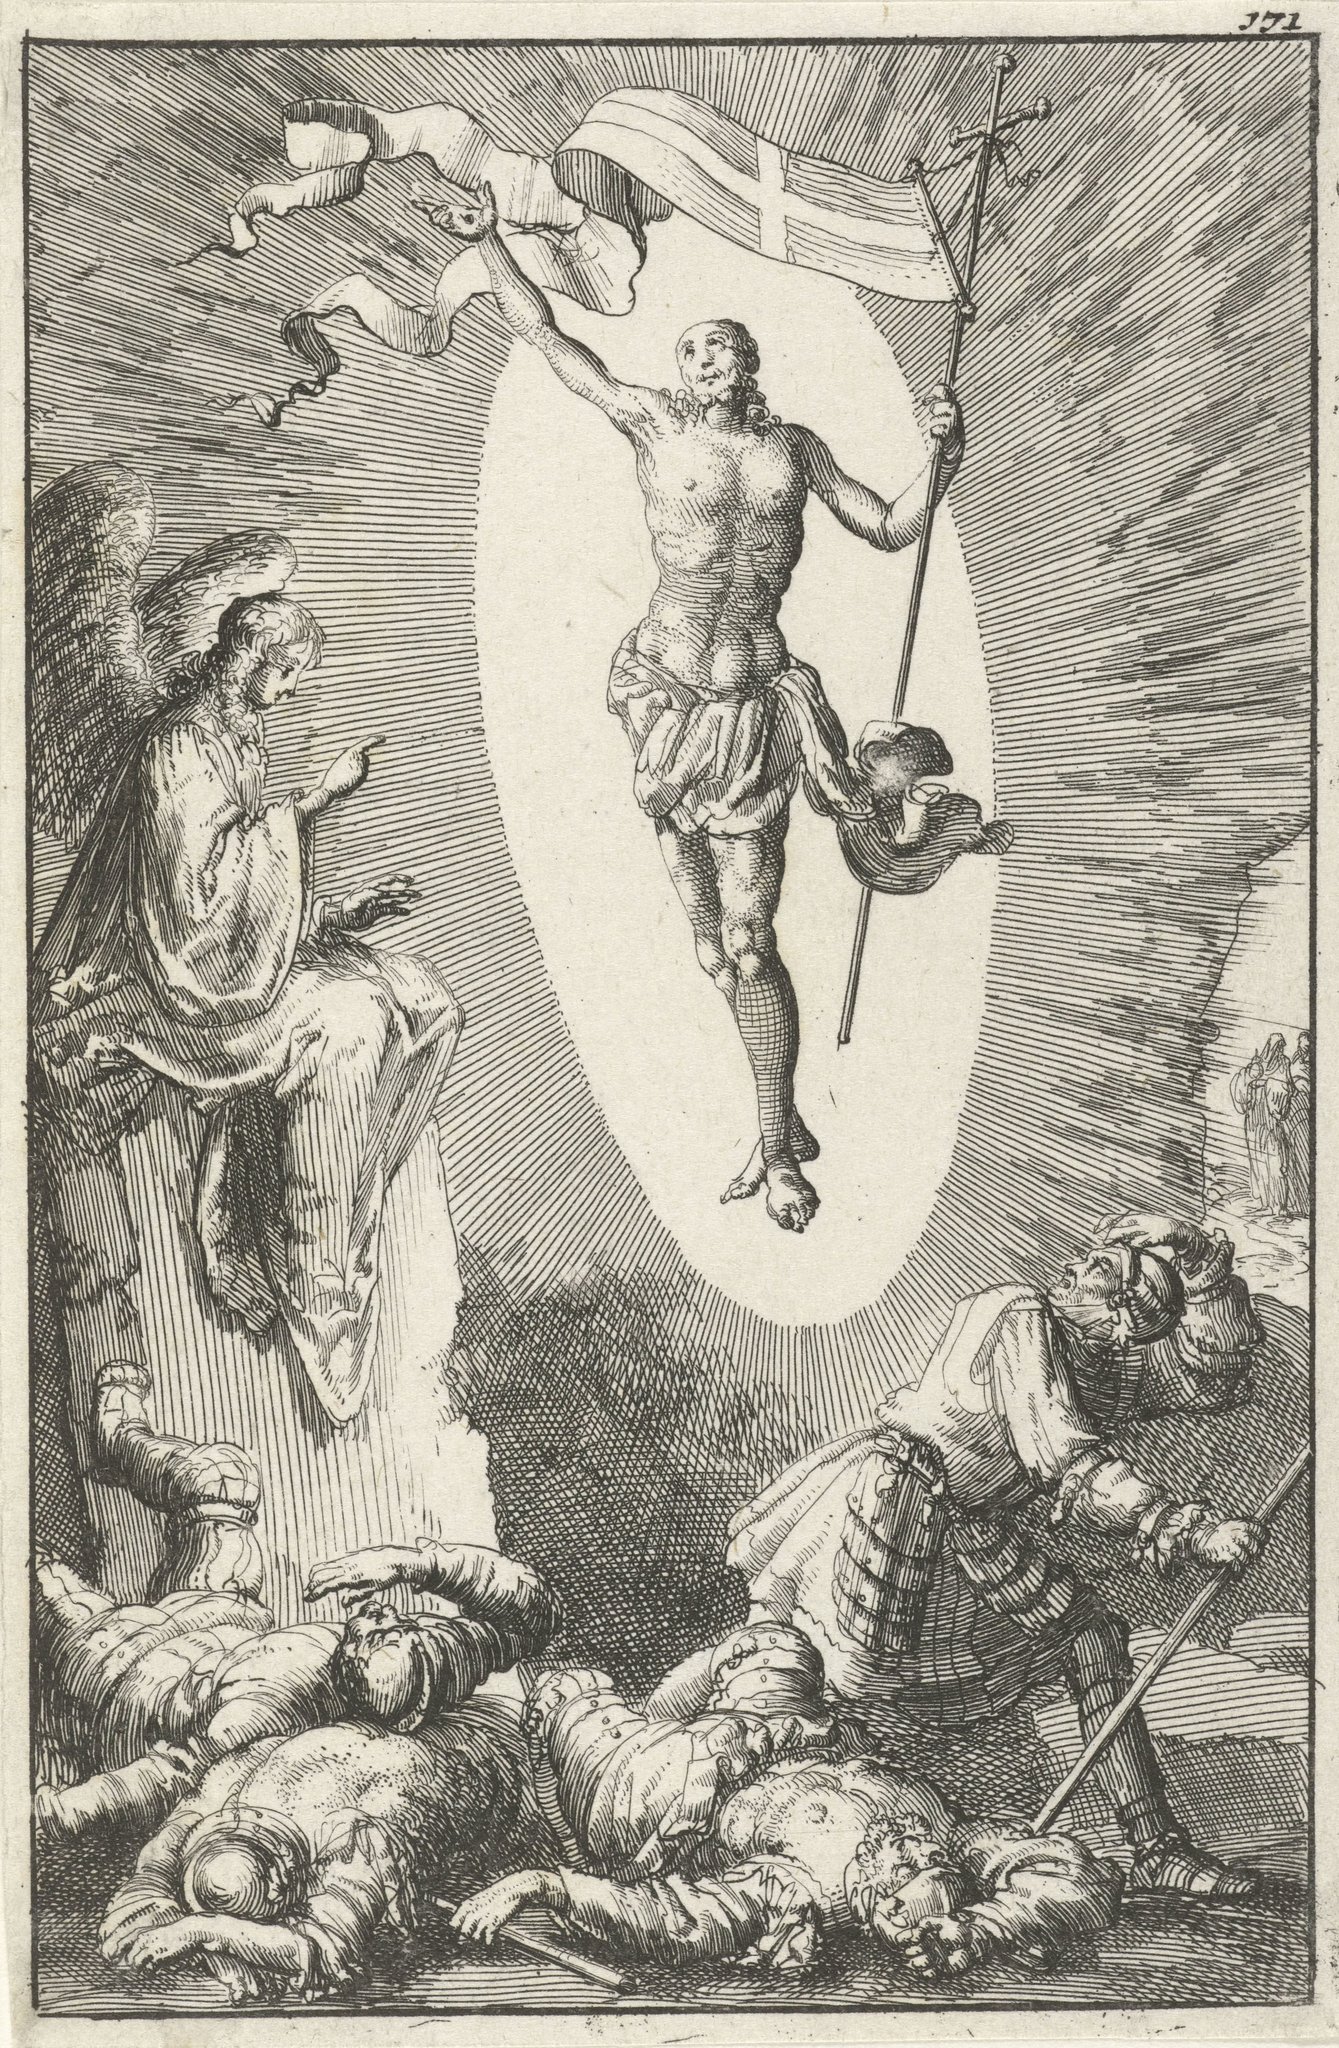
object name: print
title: Opstanding van Christus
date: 1684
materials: paper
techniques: etching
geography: amsterdam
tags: christ, usually holding a banner, arises from the grave; often combined with sleeping and/or frightened soldiers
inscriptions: collector's mark: Lugt 2228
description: Illustratie uit: Langedult, Petrus. Christus lydende, en verheerlykt. Het allerheylsaamste treur-spel. Amsterdam: Aart Dircksz Oossaan, 1684.